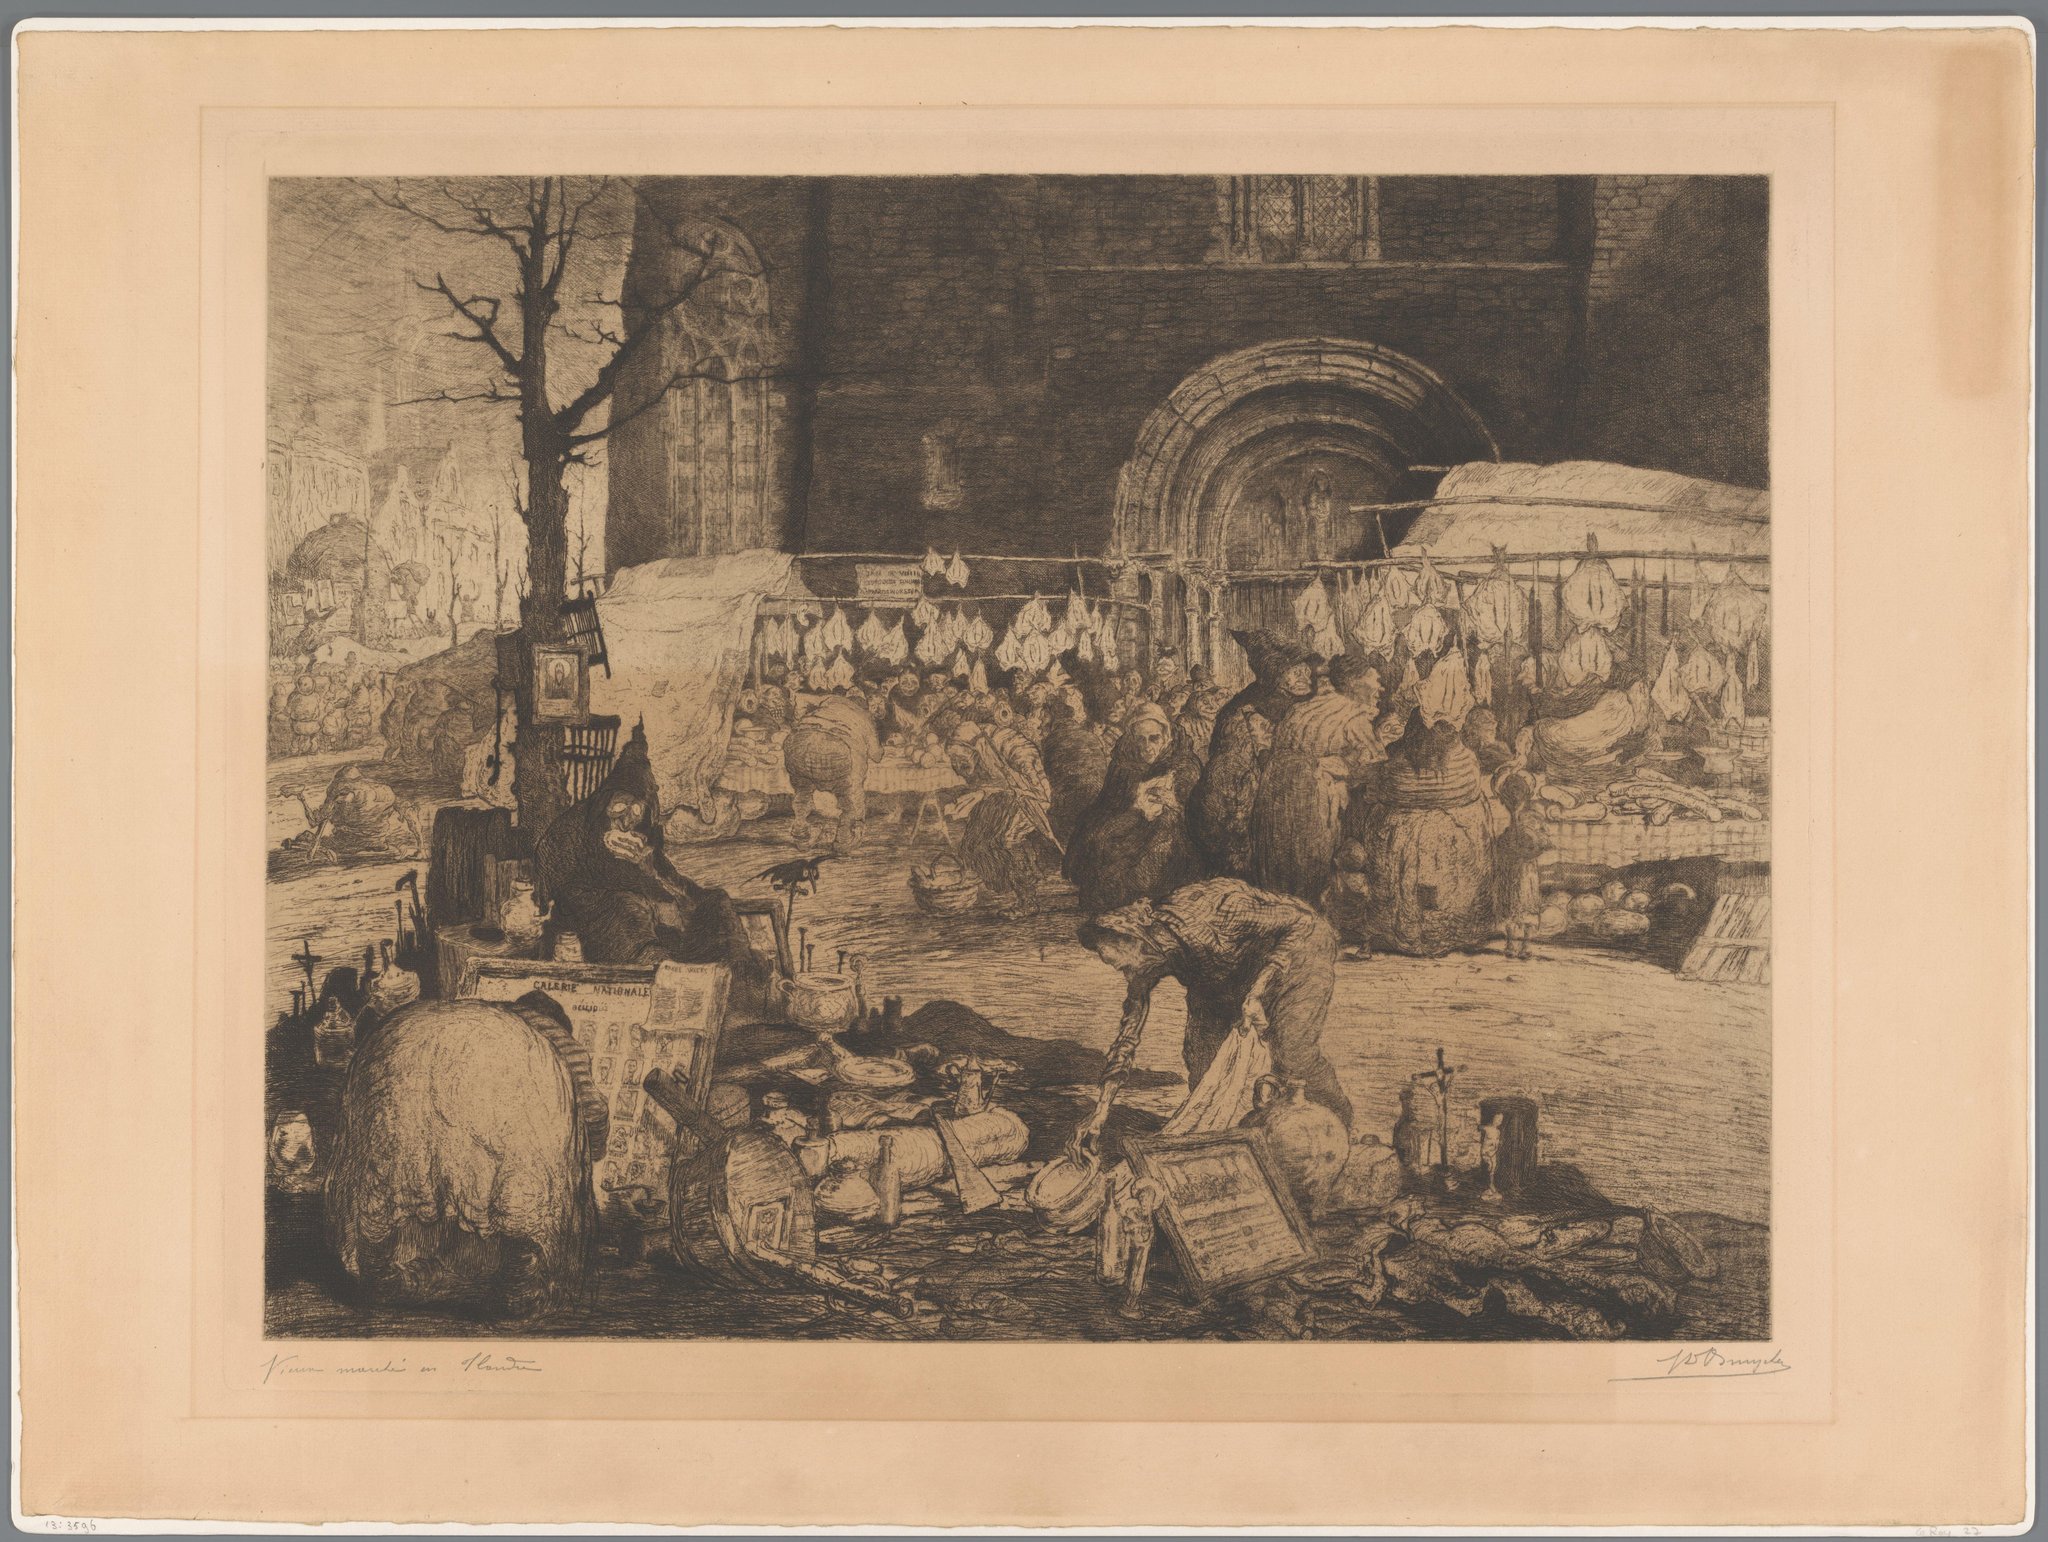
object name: print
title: Gezicht op een markt in Vlaanderen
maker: jules de bruycker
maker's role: print maker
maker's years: 1870-1945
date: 1907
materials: paper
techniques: etching, intaglio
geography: belgium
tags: antique dealer, church (exterior), market, ghent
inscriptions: collector's mark: Lugt 2233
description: Deze prent staat ook bekend als 'Oude markt in Gent'.